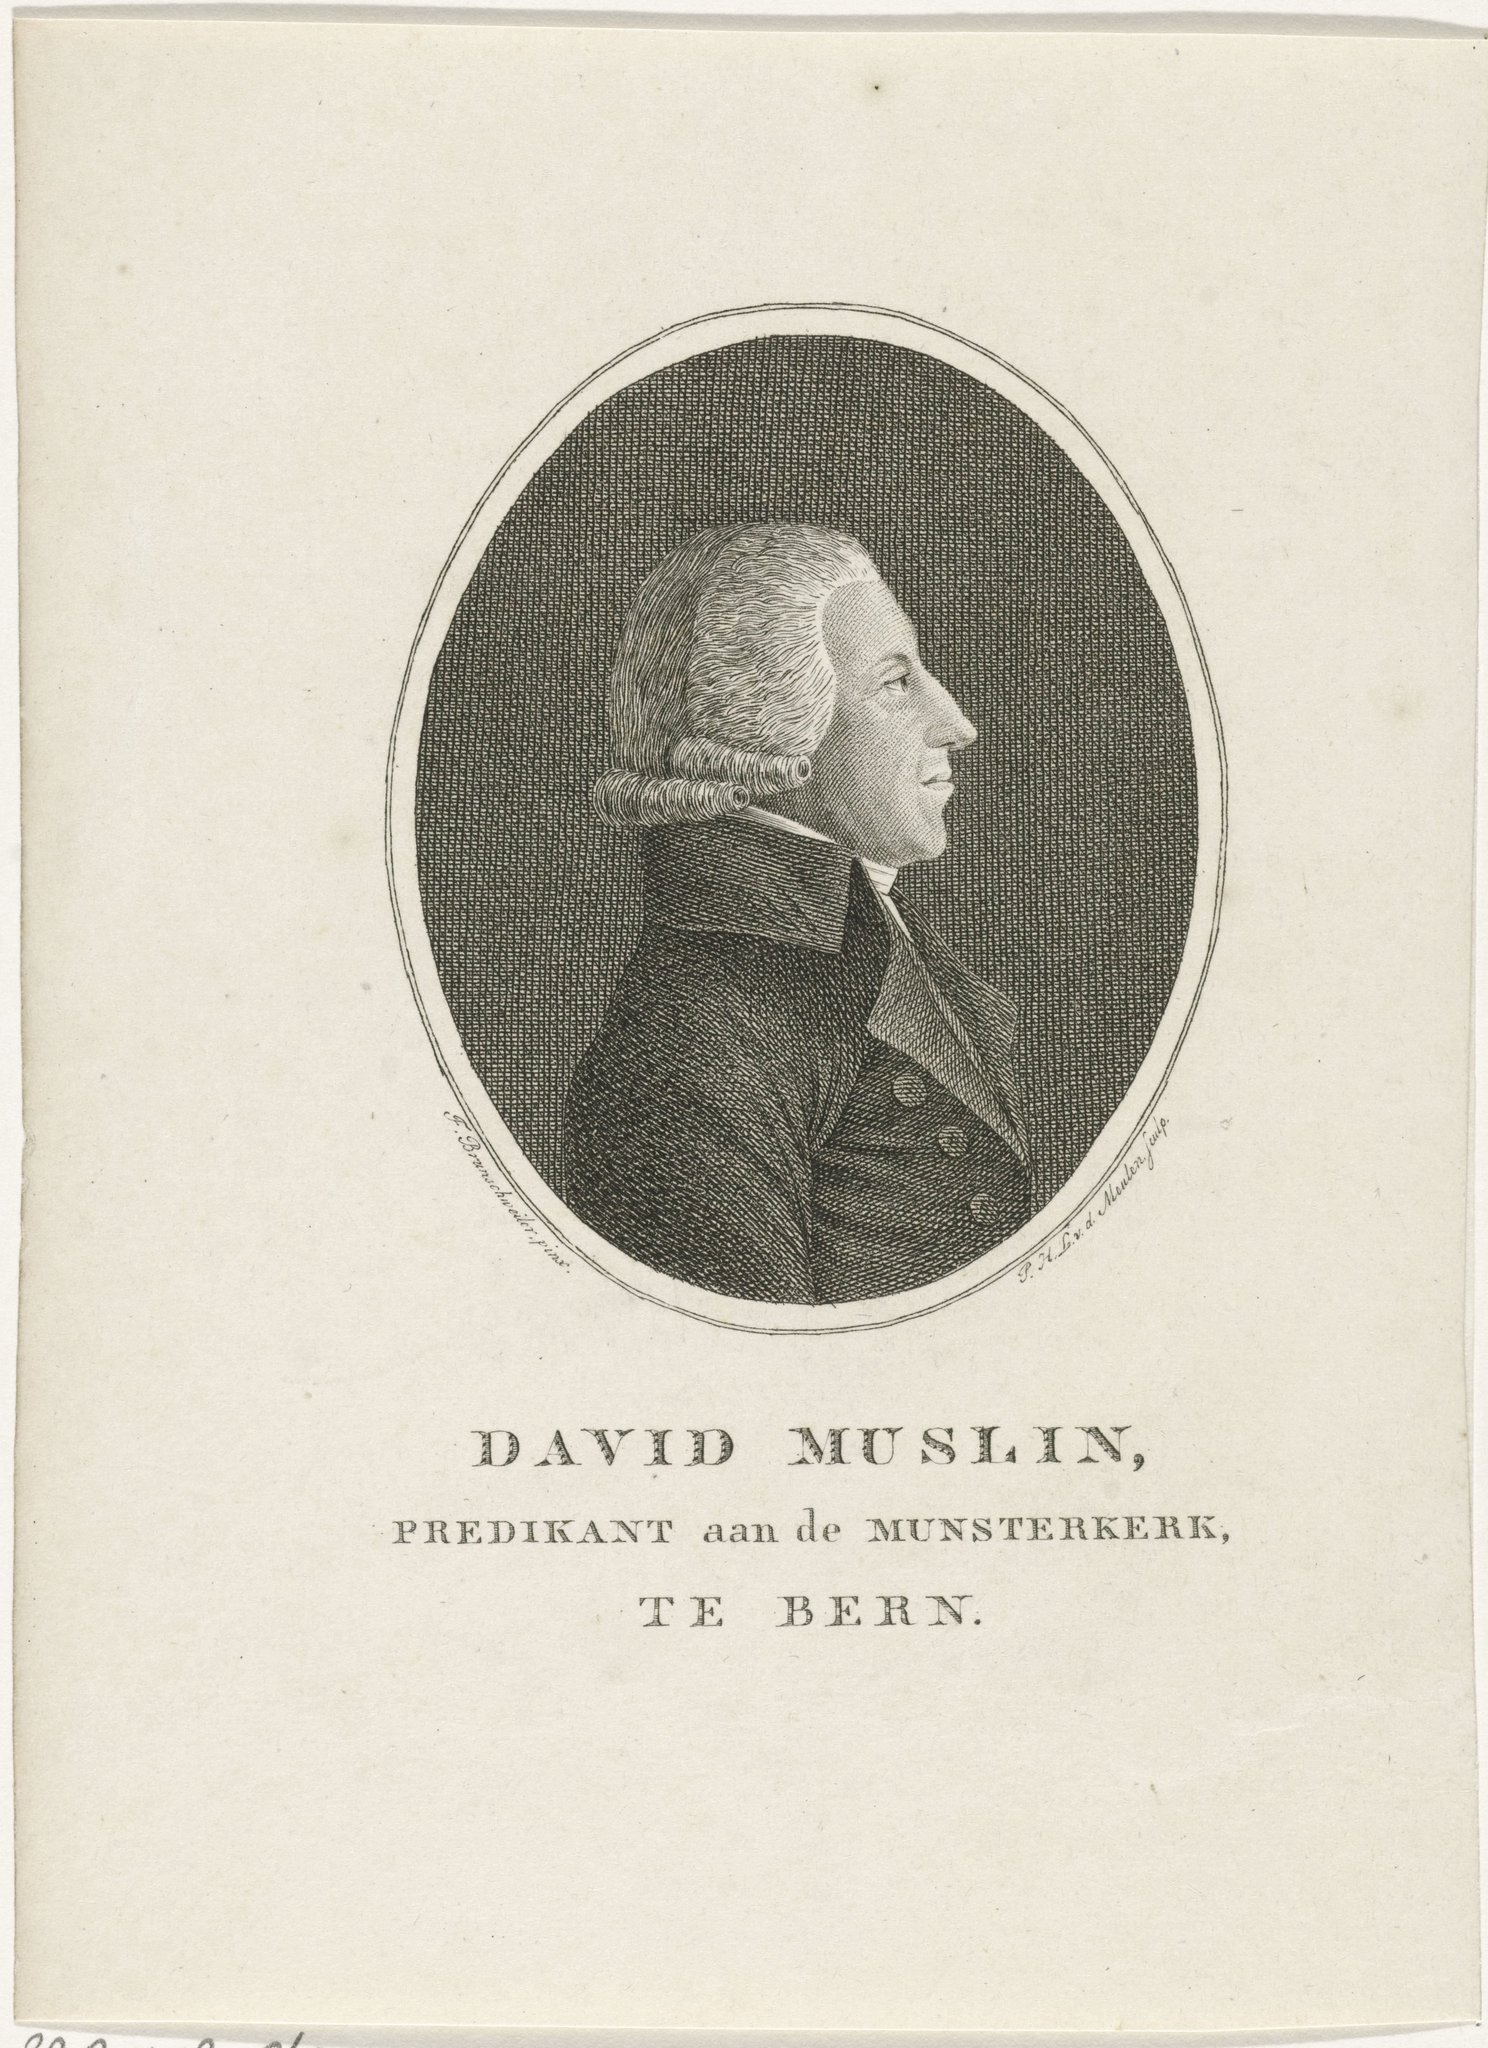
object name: print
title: Portret van David Müslin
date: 1790-1858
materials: paper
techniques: etching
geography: amsterdam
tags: predikant, theoloog, david müslin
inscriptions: collector's mark: Lugt 2228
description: Portret van David Müslin, predikant in de Munsterkerk te Bern.